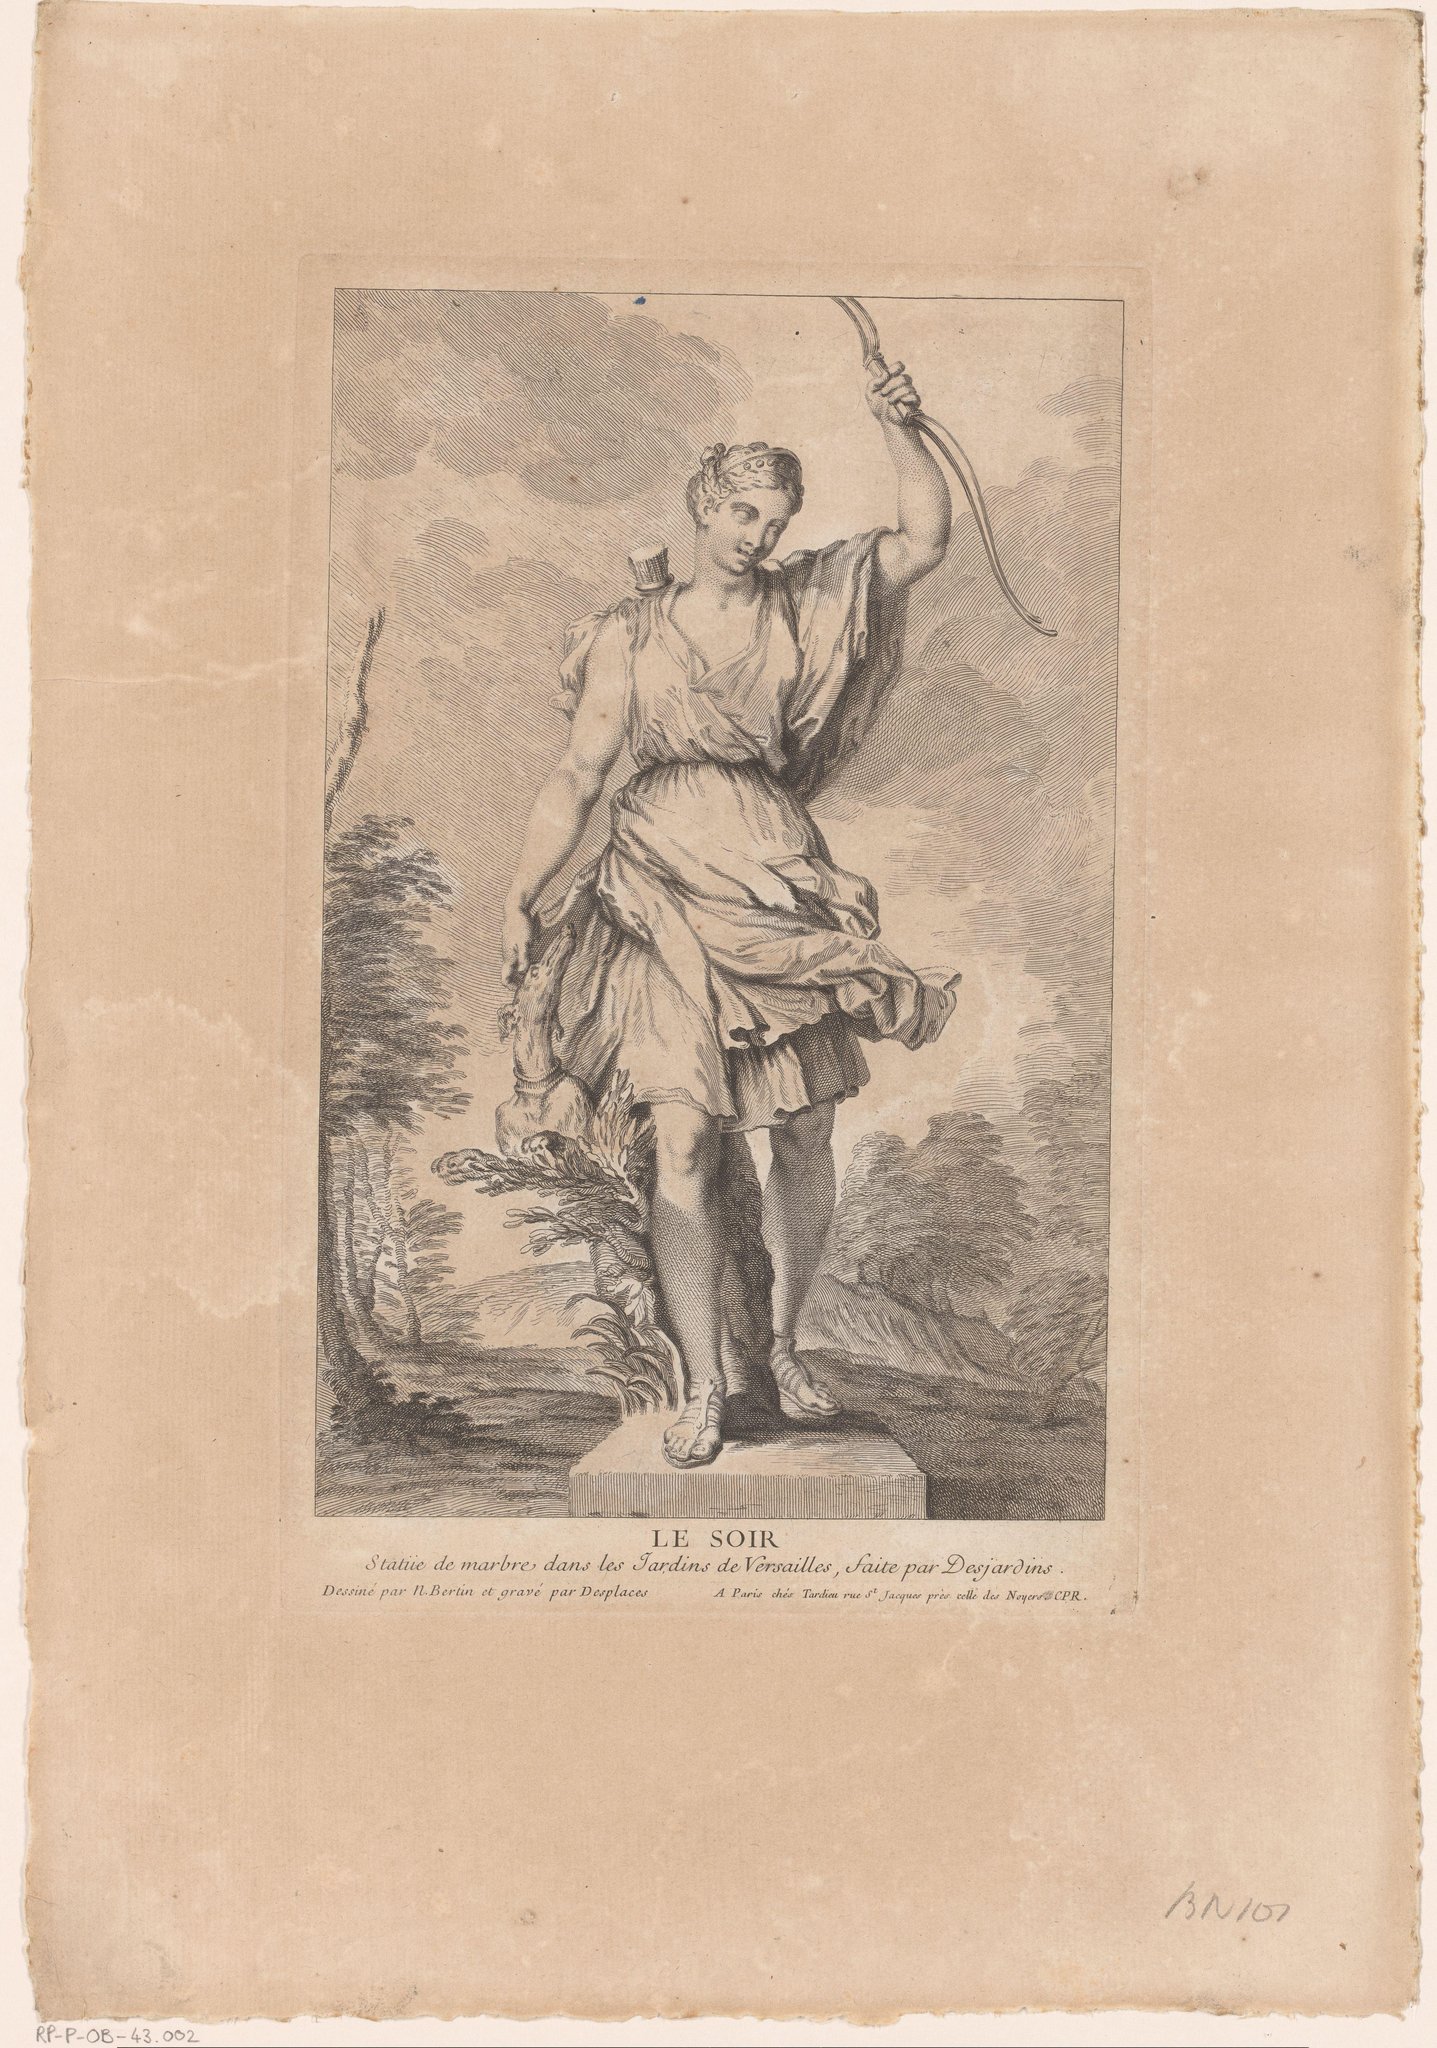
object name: print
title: Le Soir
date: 1692-1739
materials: paper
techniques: engraving, etching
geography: france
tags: personification of the evening, 'vesper', piece of sculpture, reproduction of a piece of sculpture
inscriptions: collector's mark: Lugt 2228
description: Maakt deel uit van een vierdelige serie naar beelden van de vier dagdelen.